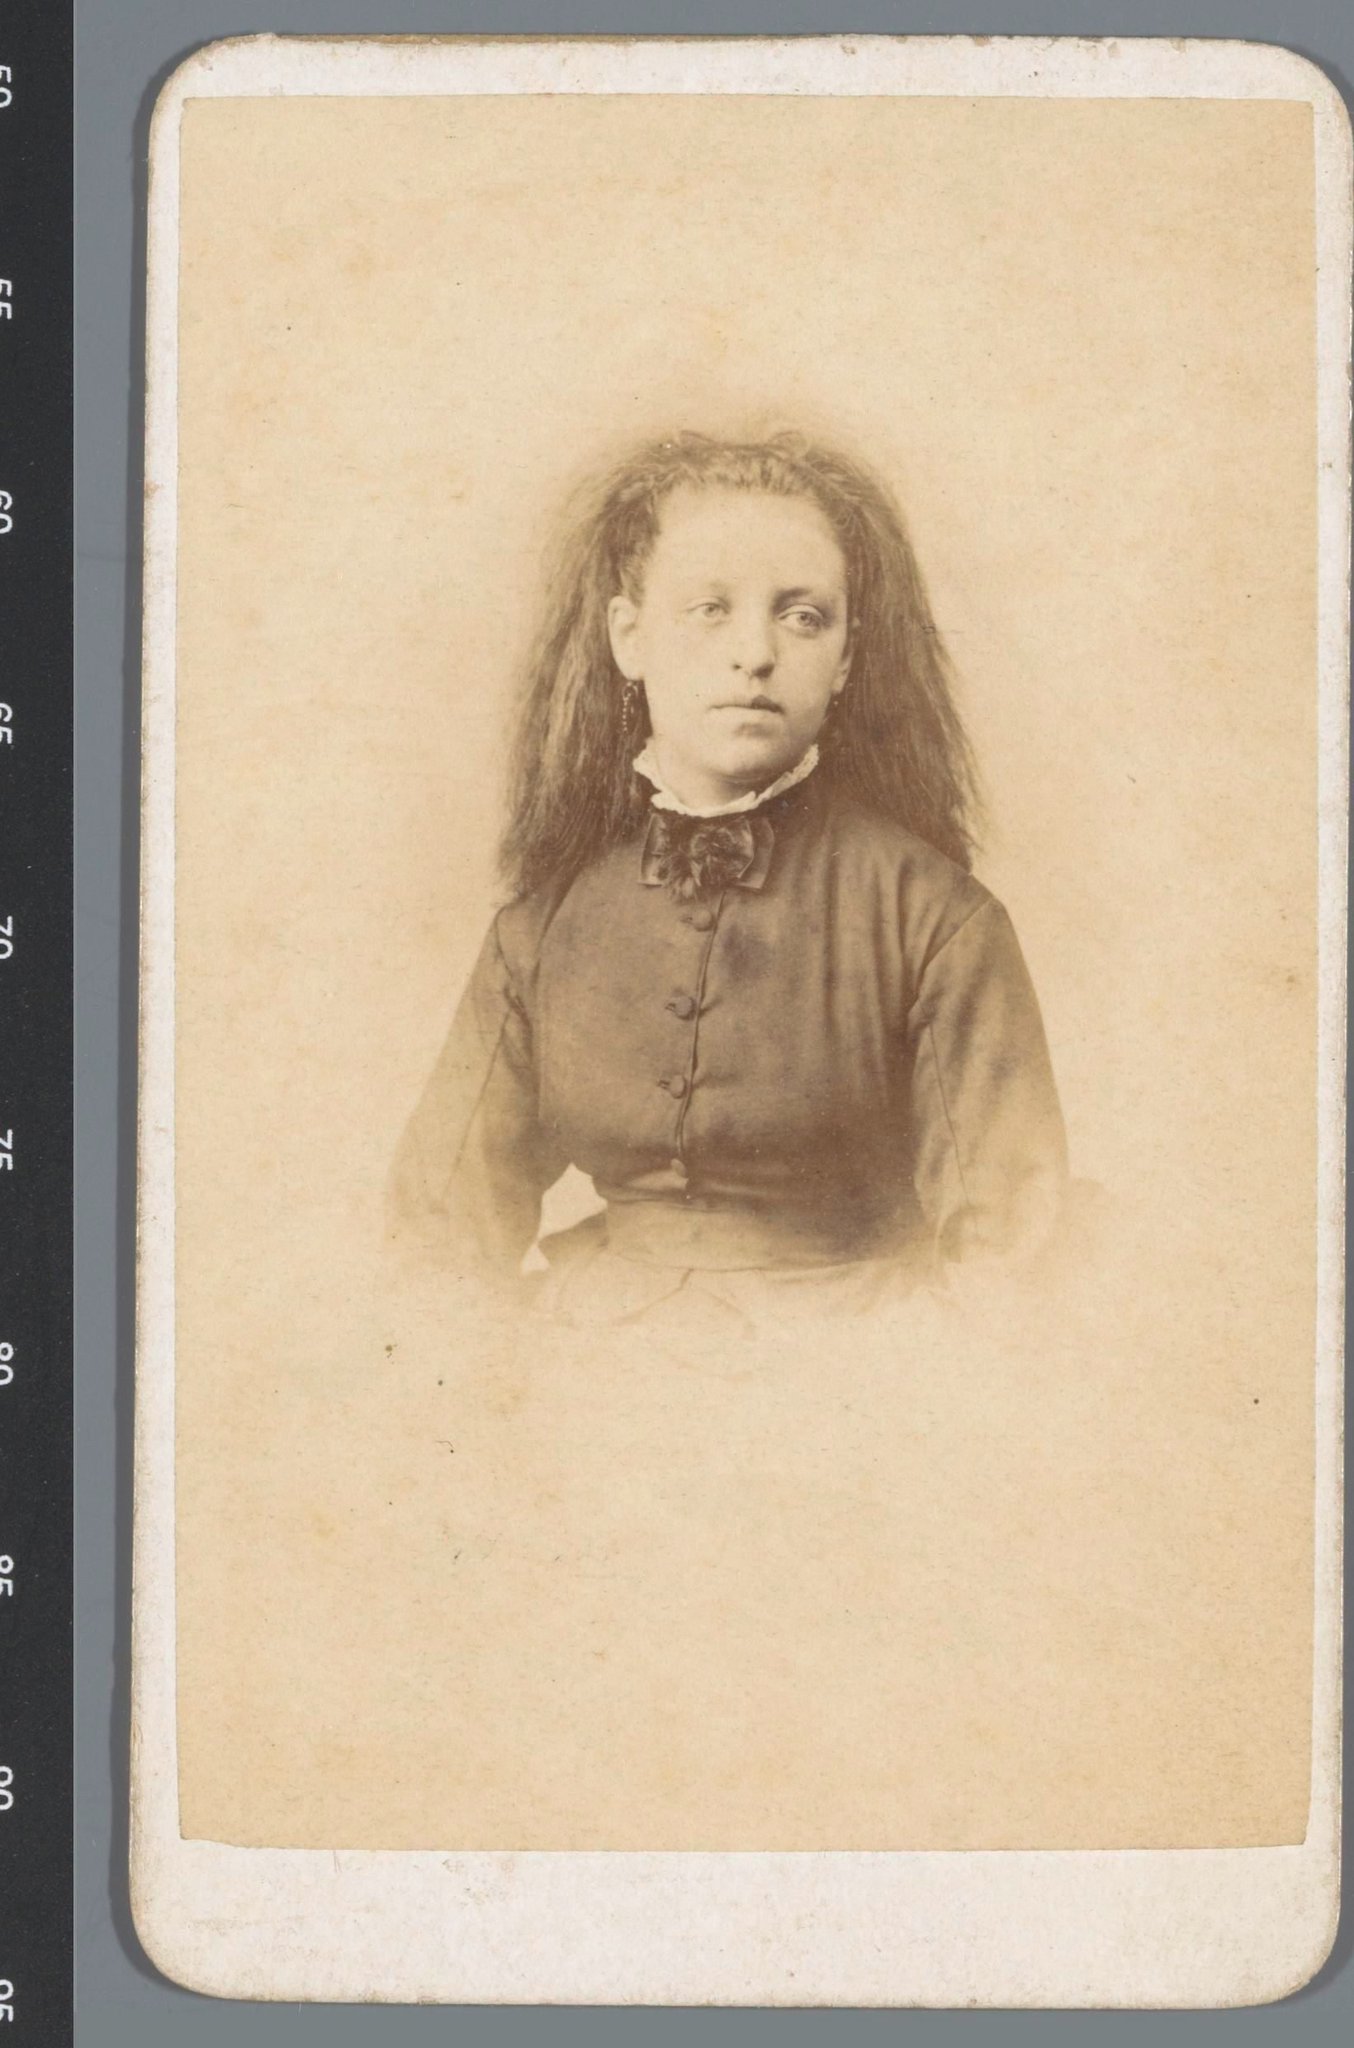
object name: photograph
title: Portret van een onbekend meisje met los haar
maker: dirk niekerk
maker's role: fotograaf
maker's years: 1824-1881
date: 1873-1879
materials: cardboard, paper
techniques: albumen print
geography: amsterdam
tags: girl (child between toddler and youth), anonymous historical person portrayed, amsterdam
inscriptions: inscription: ‘A.M.’, inscription: ‘D. Niekerk/ Photograaf van Z.K.H. Prins Hendrik/ der Nederlanden./ Kadijksplein,/ bij de Kattenburgerbrug. U.434a./ Amsterdam.’